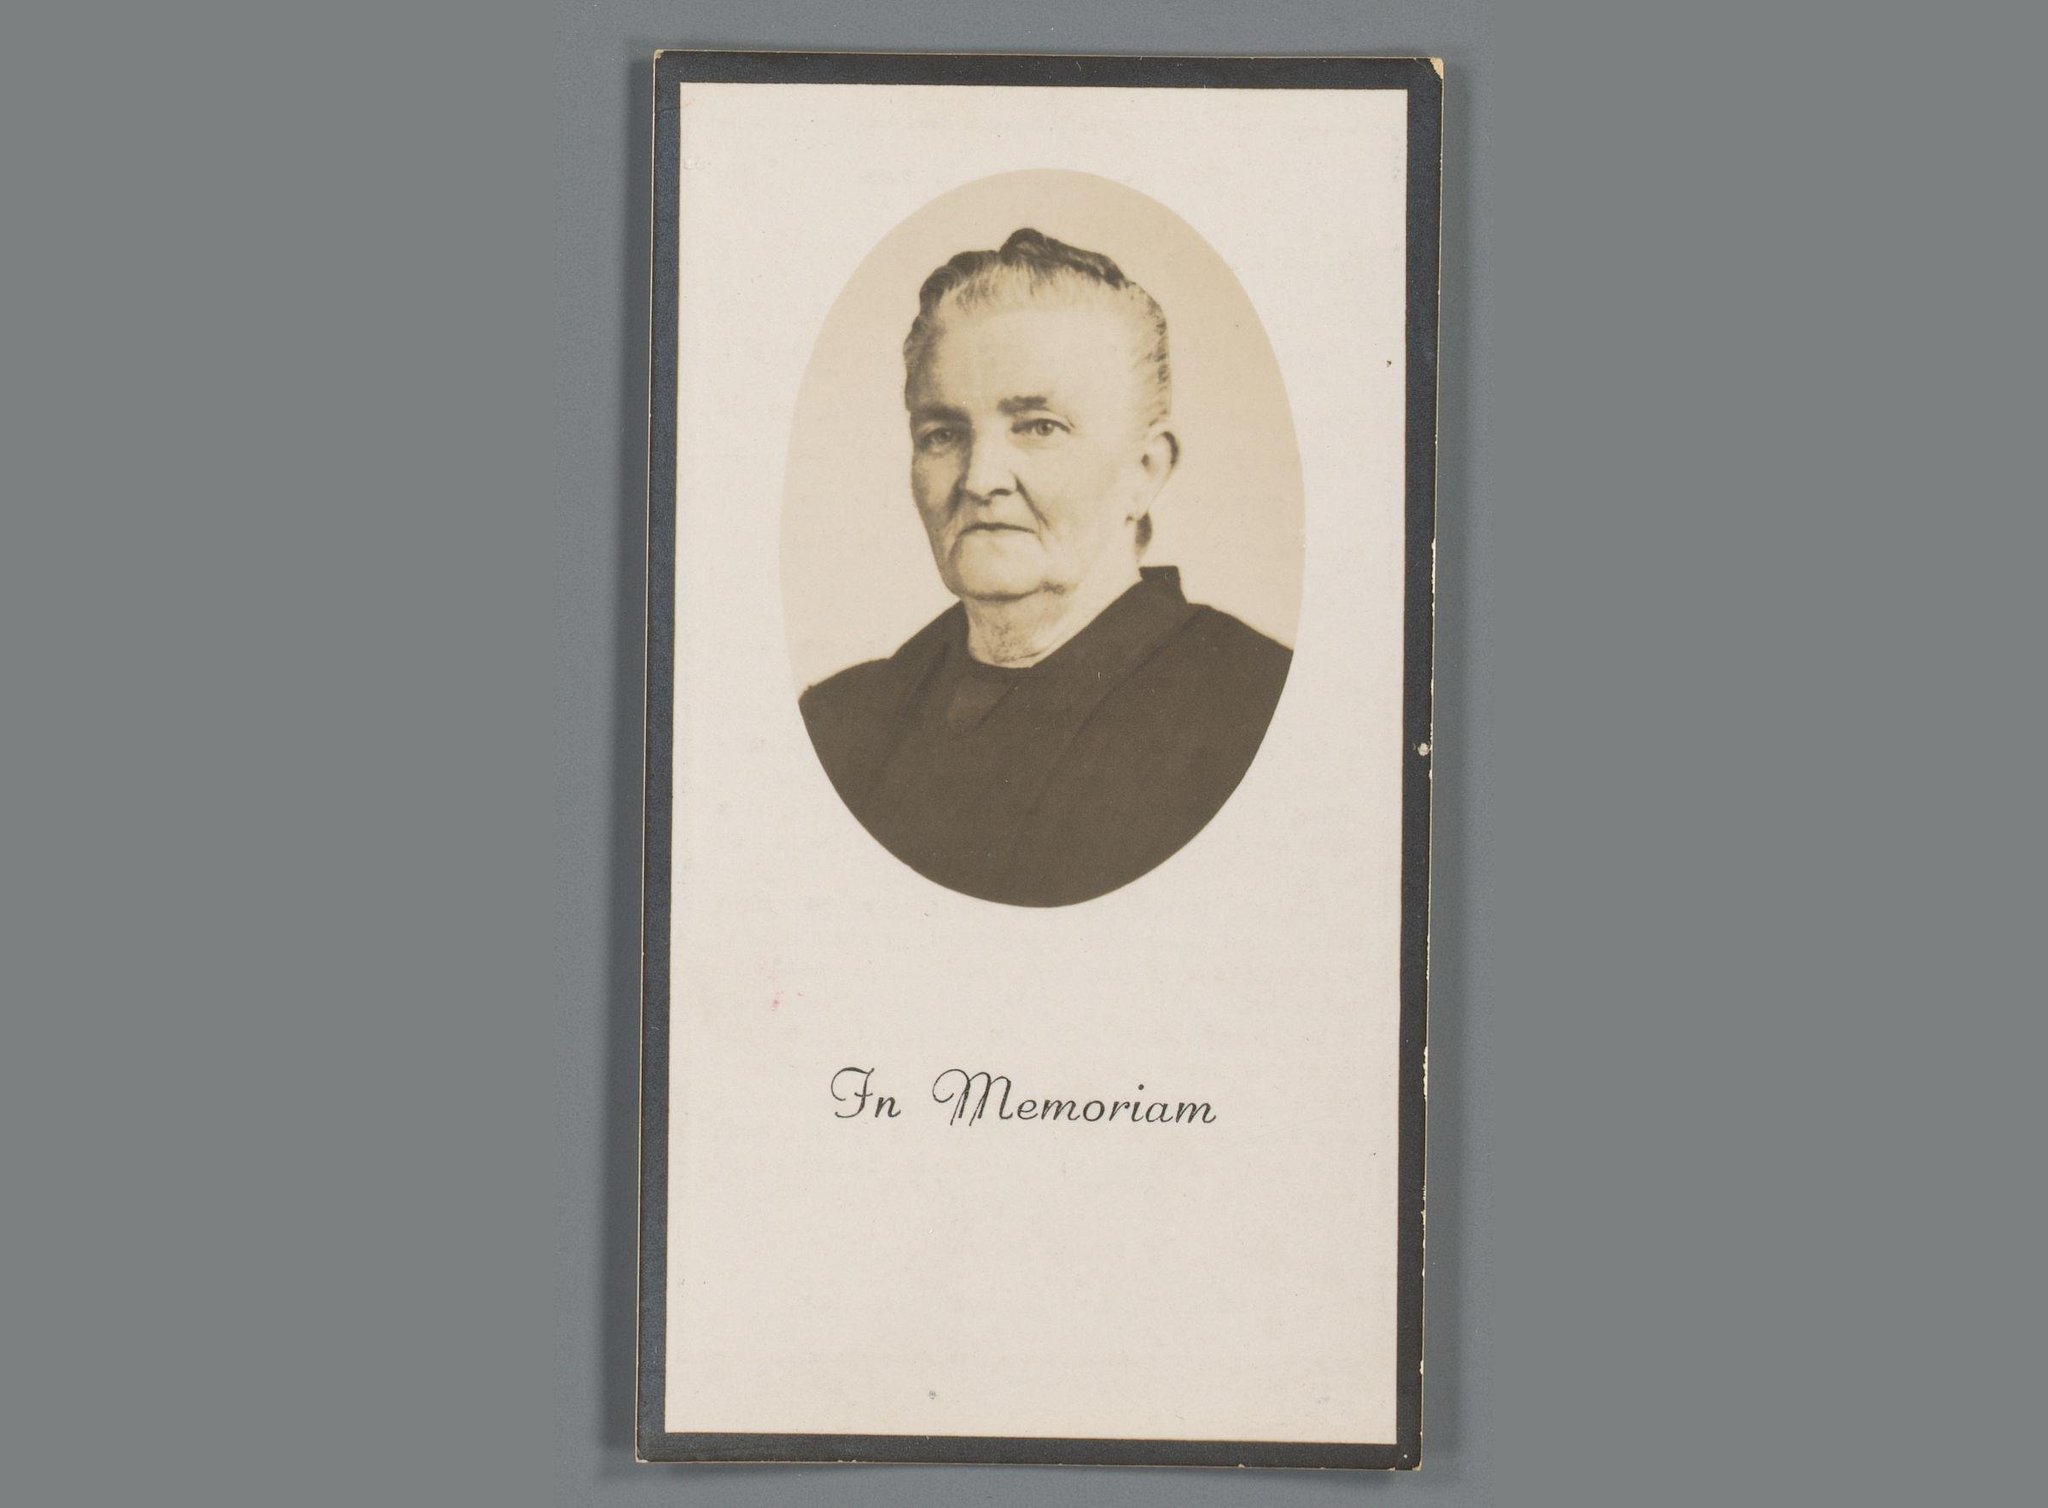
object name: prayer card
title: Portret van Maria Catharina Beentjes-de Boer op bidprent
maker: Anonymous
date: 1944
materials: paper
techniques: gelatin silver print, letterpress printing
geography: hoorn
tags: hoorn (north holland), historical persons, old woman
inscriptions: inscription: ‘Ter nagedachtenis van (...) Gedenkt haar in Uw gebeden./ 1523’